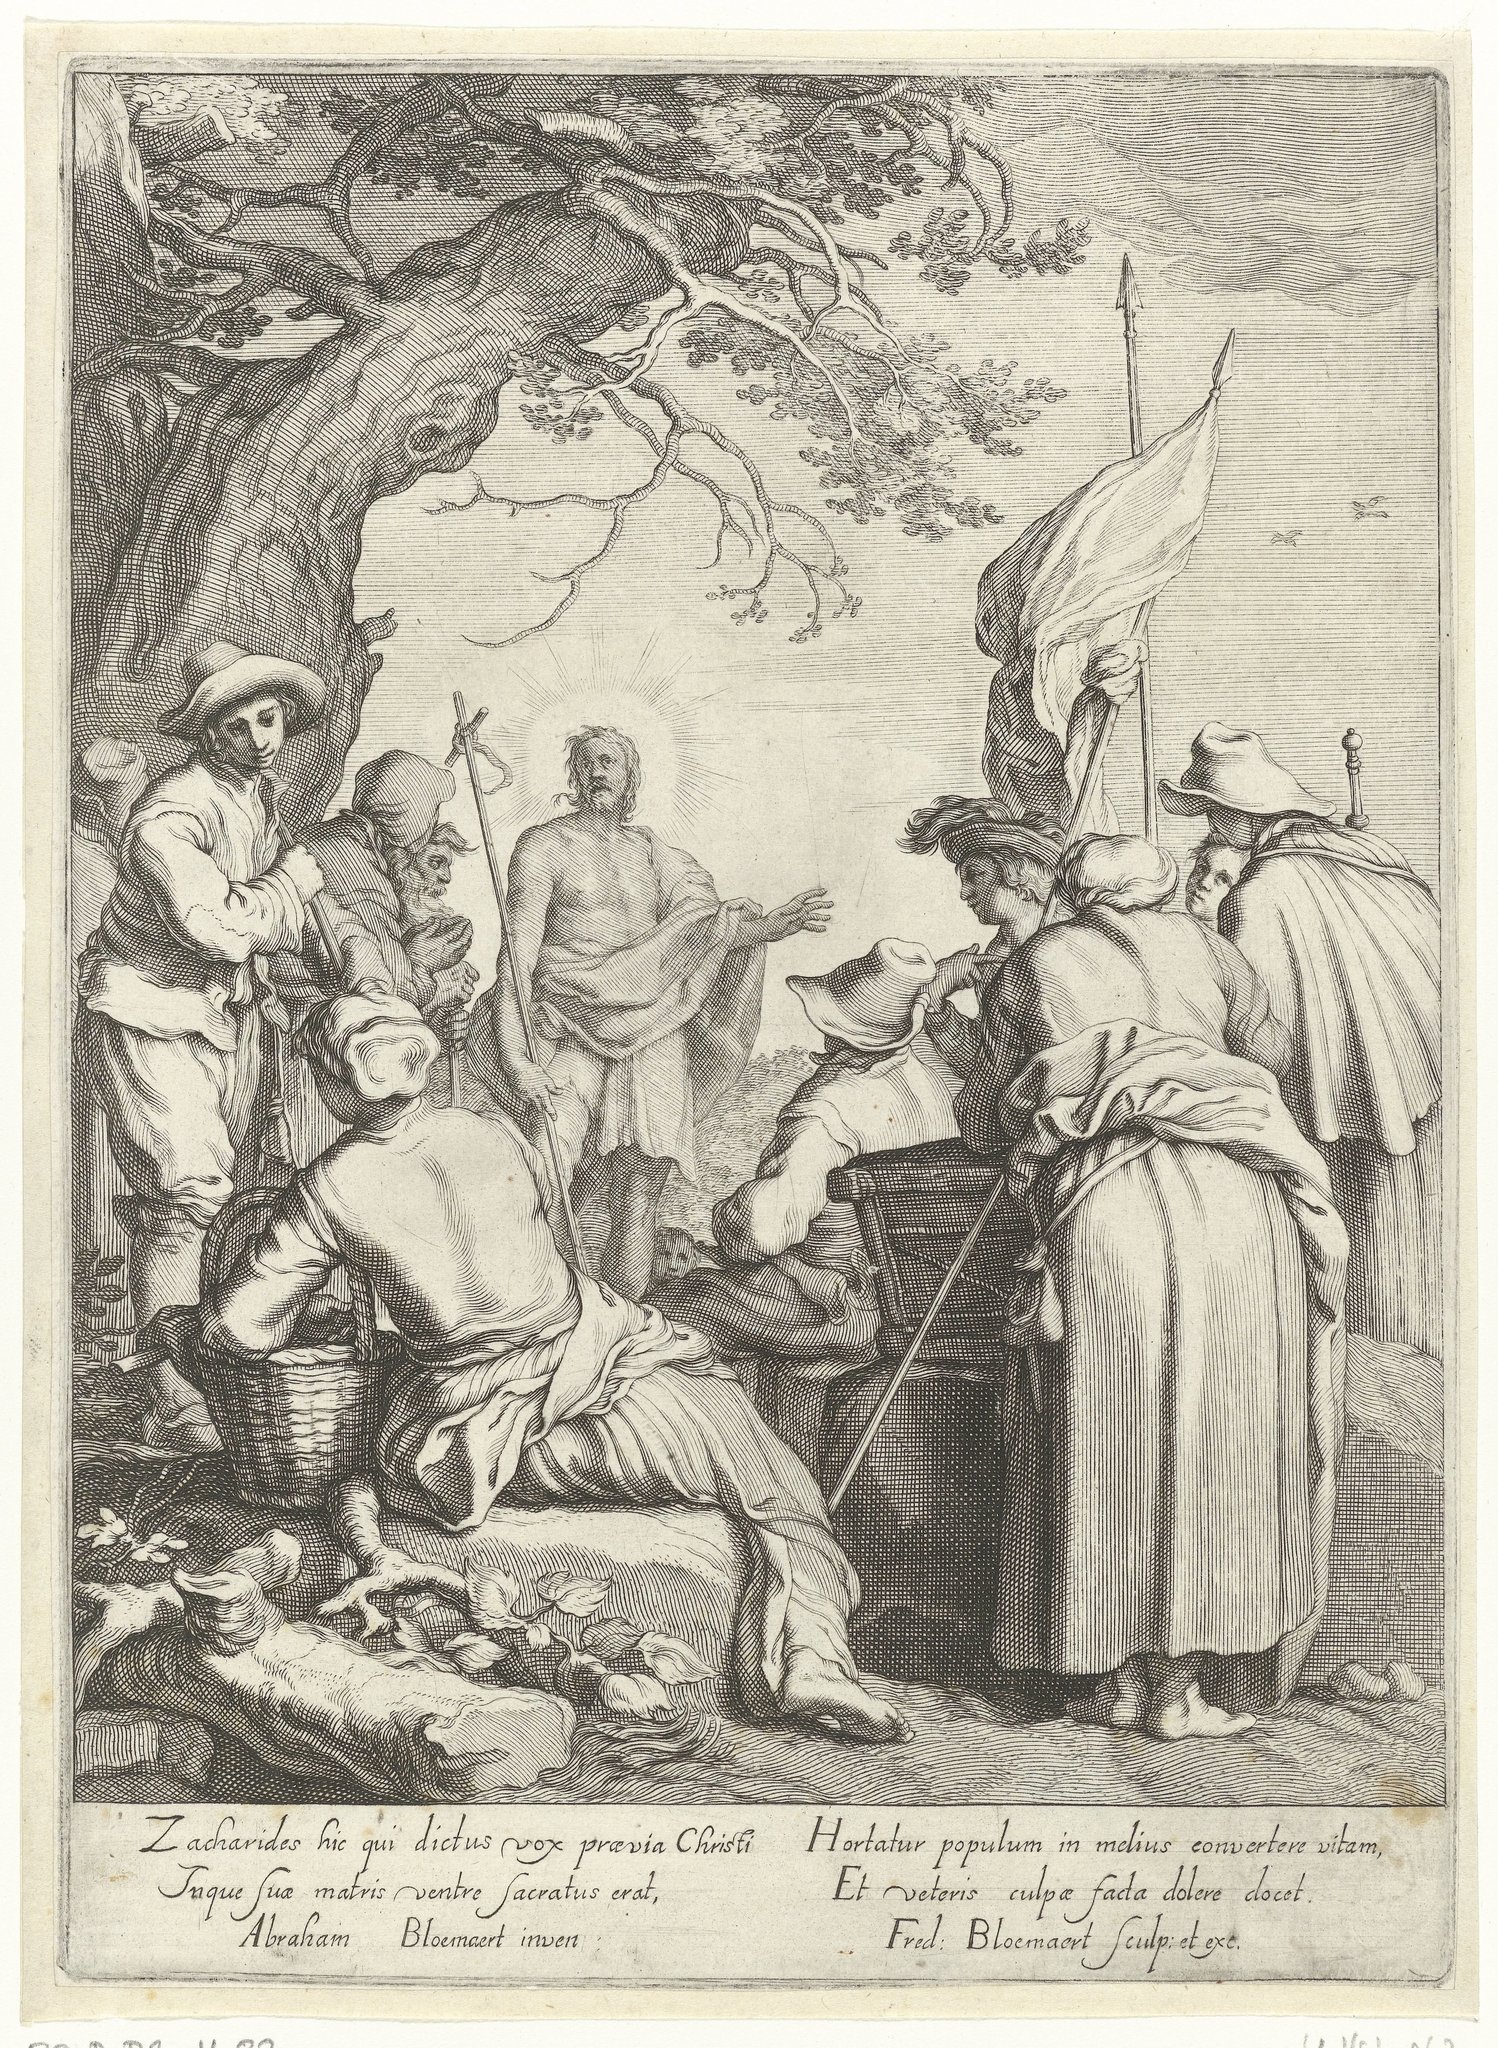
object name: print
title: Prediking van Johannes de Doper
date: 1632-1670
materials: paper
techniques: engraving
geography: utrecht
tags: john the baptist preaching (perhaps christ among the bystanders)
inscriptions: collector's mark: Lugt 240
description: Johannes de Doper met zijn attribuut, een rieten kruis, staat hier te preken temidden van het volk. Met Latijns onderschrift.